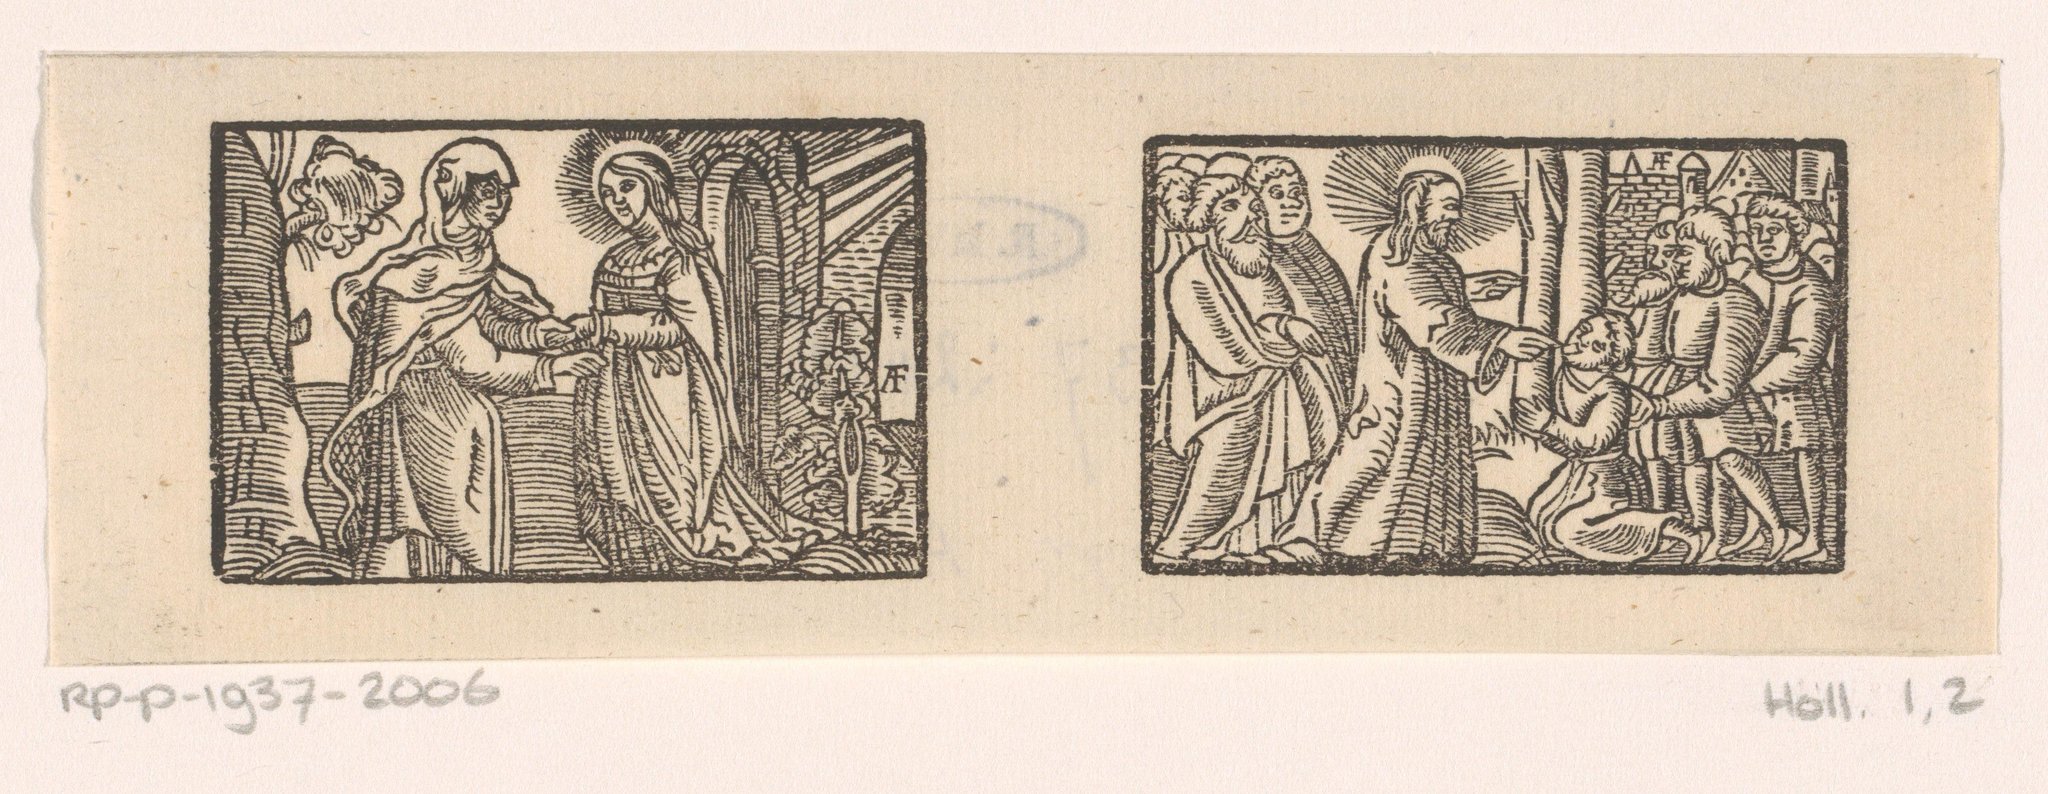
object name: print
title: Visitatie en Christus geneest een doofstomme man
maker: monogrammist af (16e eeuw)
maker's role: print maker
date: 1550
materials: paper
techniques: woodcut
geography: netherlands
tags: healing of a deaf man in decapolis (mark 7:31-37), mary and elisabeth shaking hands, deaf, deafness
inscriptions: collector's mark: Lugt 2760, collector's mark: Lugt 2228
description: Voorstellingen naar beschrijvingen van de Visitatie en een genezing in Marcus 7:32. Dit is in de Statenvertaling beschreven als: “En zij brachten tot Hem een dove, die zwaarlijk sprak, en baden Hem, dat Hij de hand op hem legde.”In de Nieuwe Bijbelvertaling 21 staat: “Daar werd iemand bij Hem gebracht die doof was en gebrekkig sprak, en men smeekte Hem om deze man de hand op te leggen.”